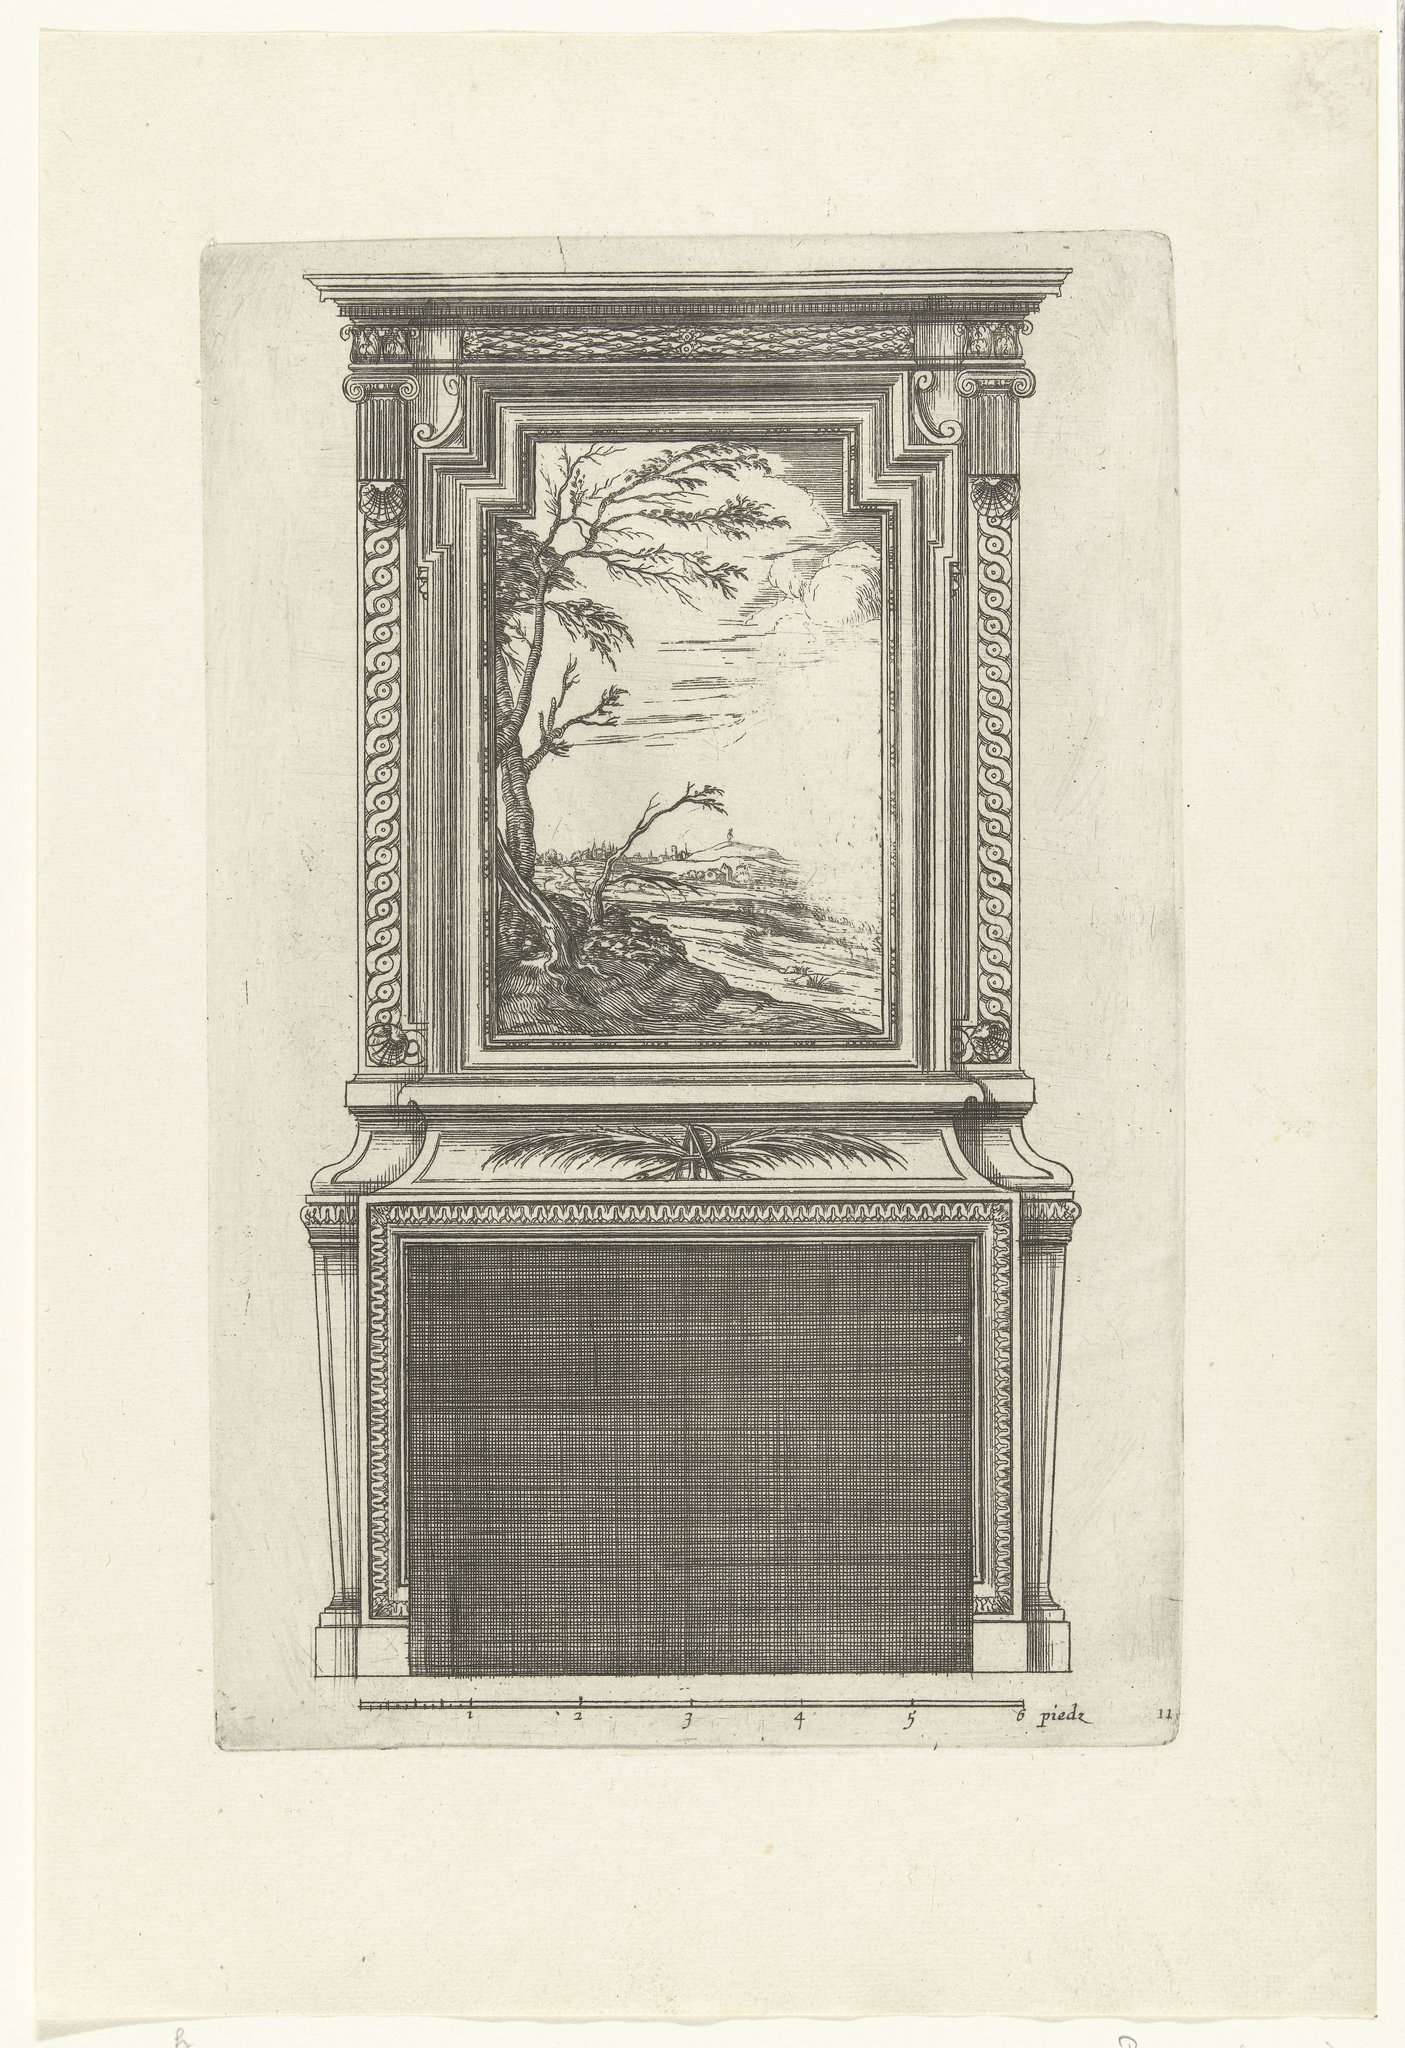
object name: print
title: Divers Desseins de cheminées à la royale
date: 1655-1657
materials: paper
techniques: engraving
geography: paris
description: Op de schoorsteenboezem staat het monogram AP. Uit tweede editie.